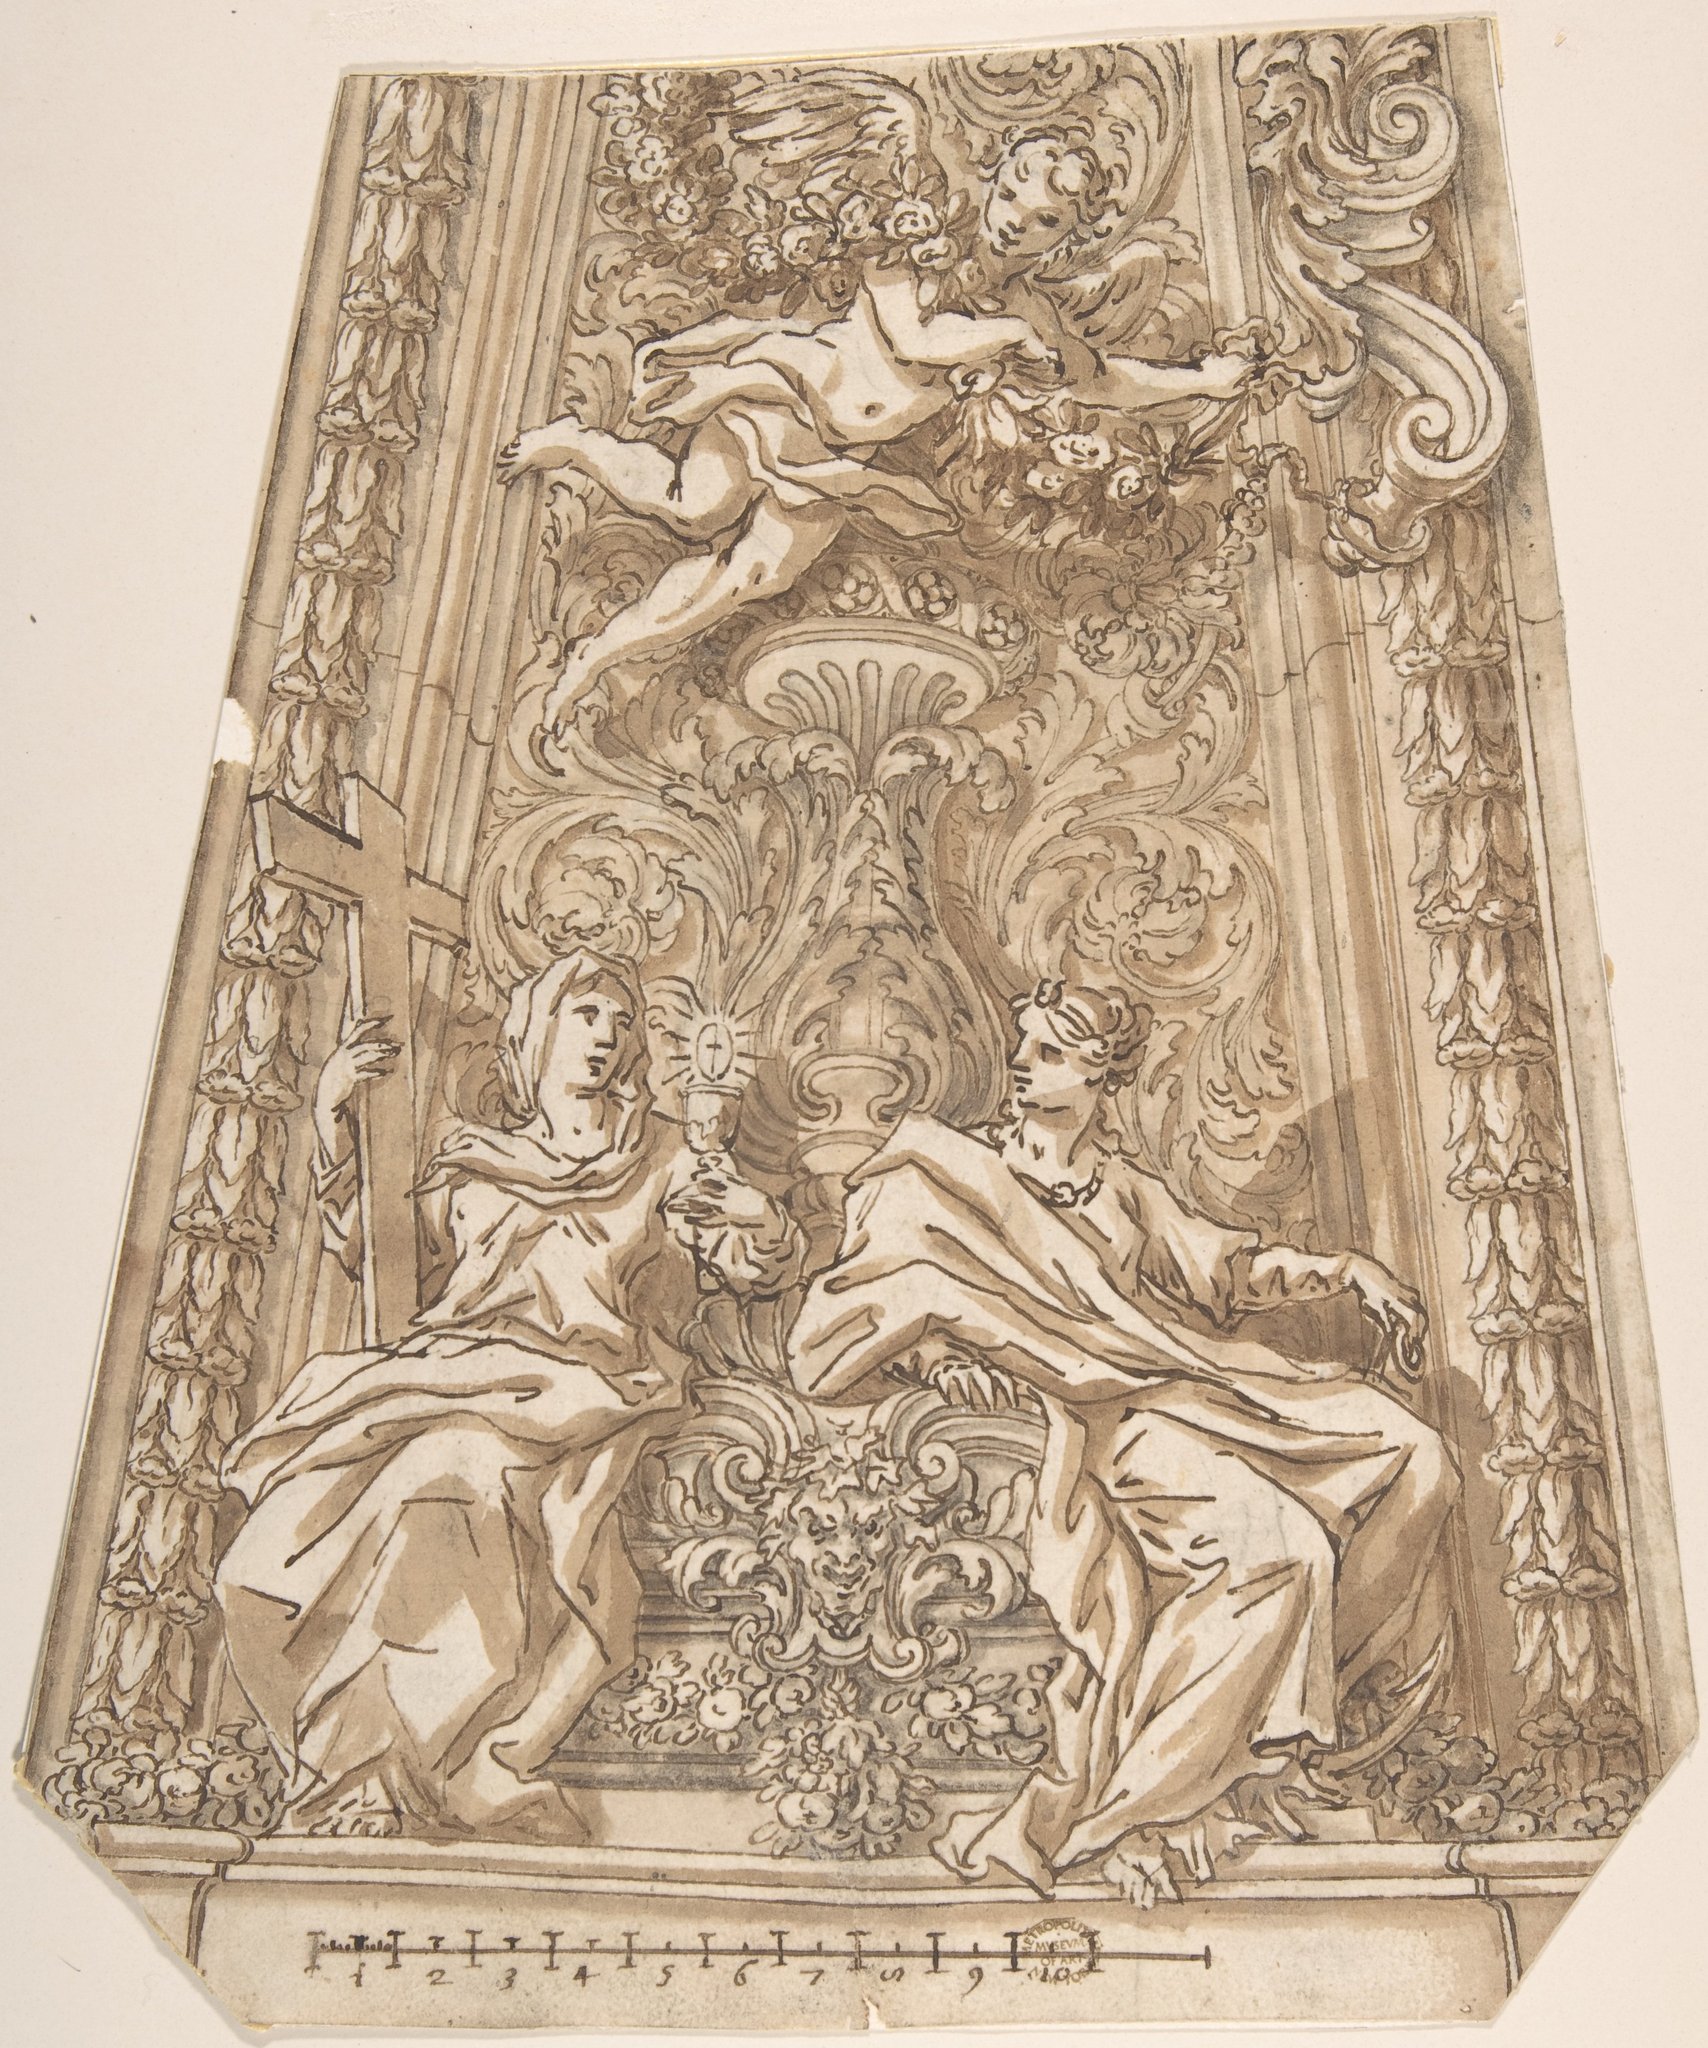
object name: drawing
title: Design for a Dome Compartment with Figures of Faith and Hope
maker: anonymous, italian, roman-bolognese, 17th century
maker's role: artist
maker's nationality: italian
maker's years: 1600-1700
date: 1601-1700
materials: chalk, ink, paper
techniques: brush, pen, wash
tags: women,angels,cross